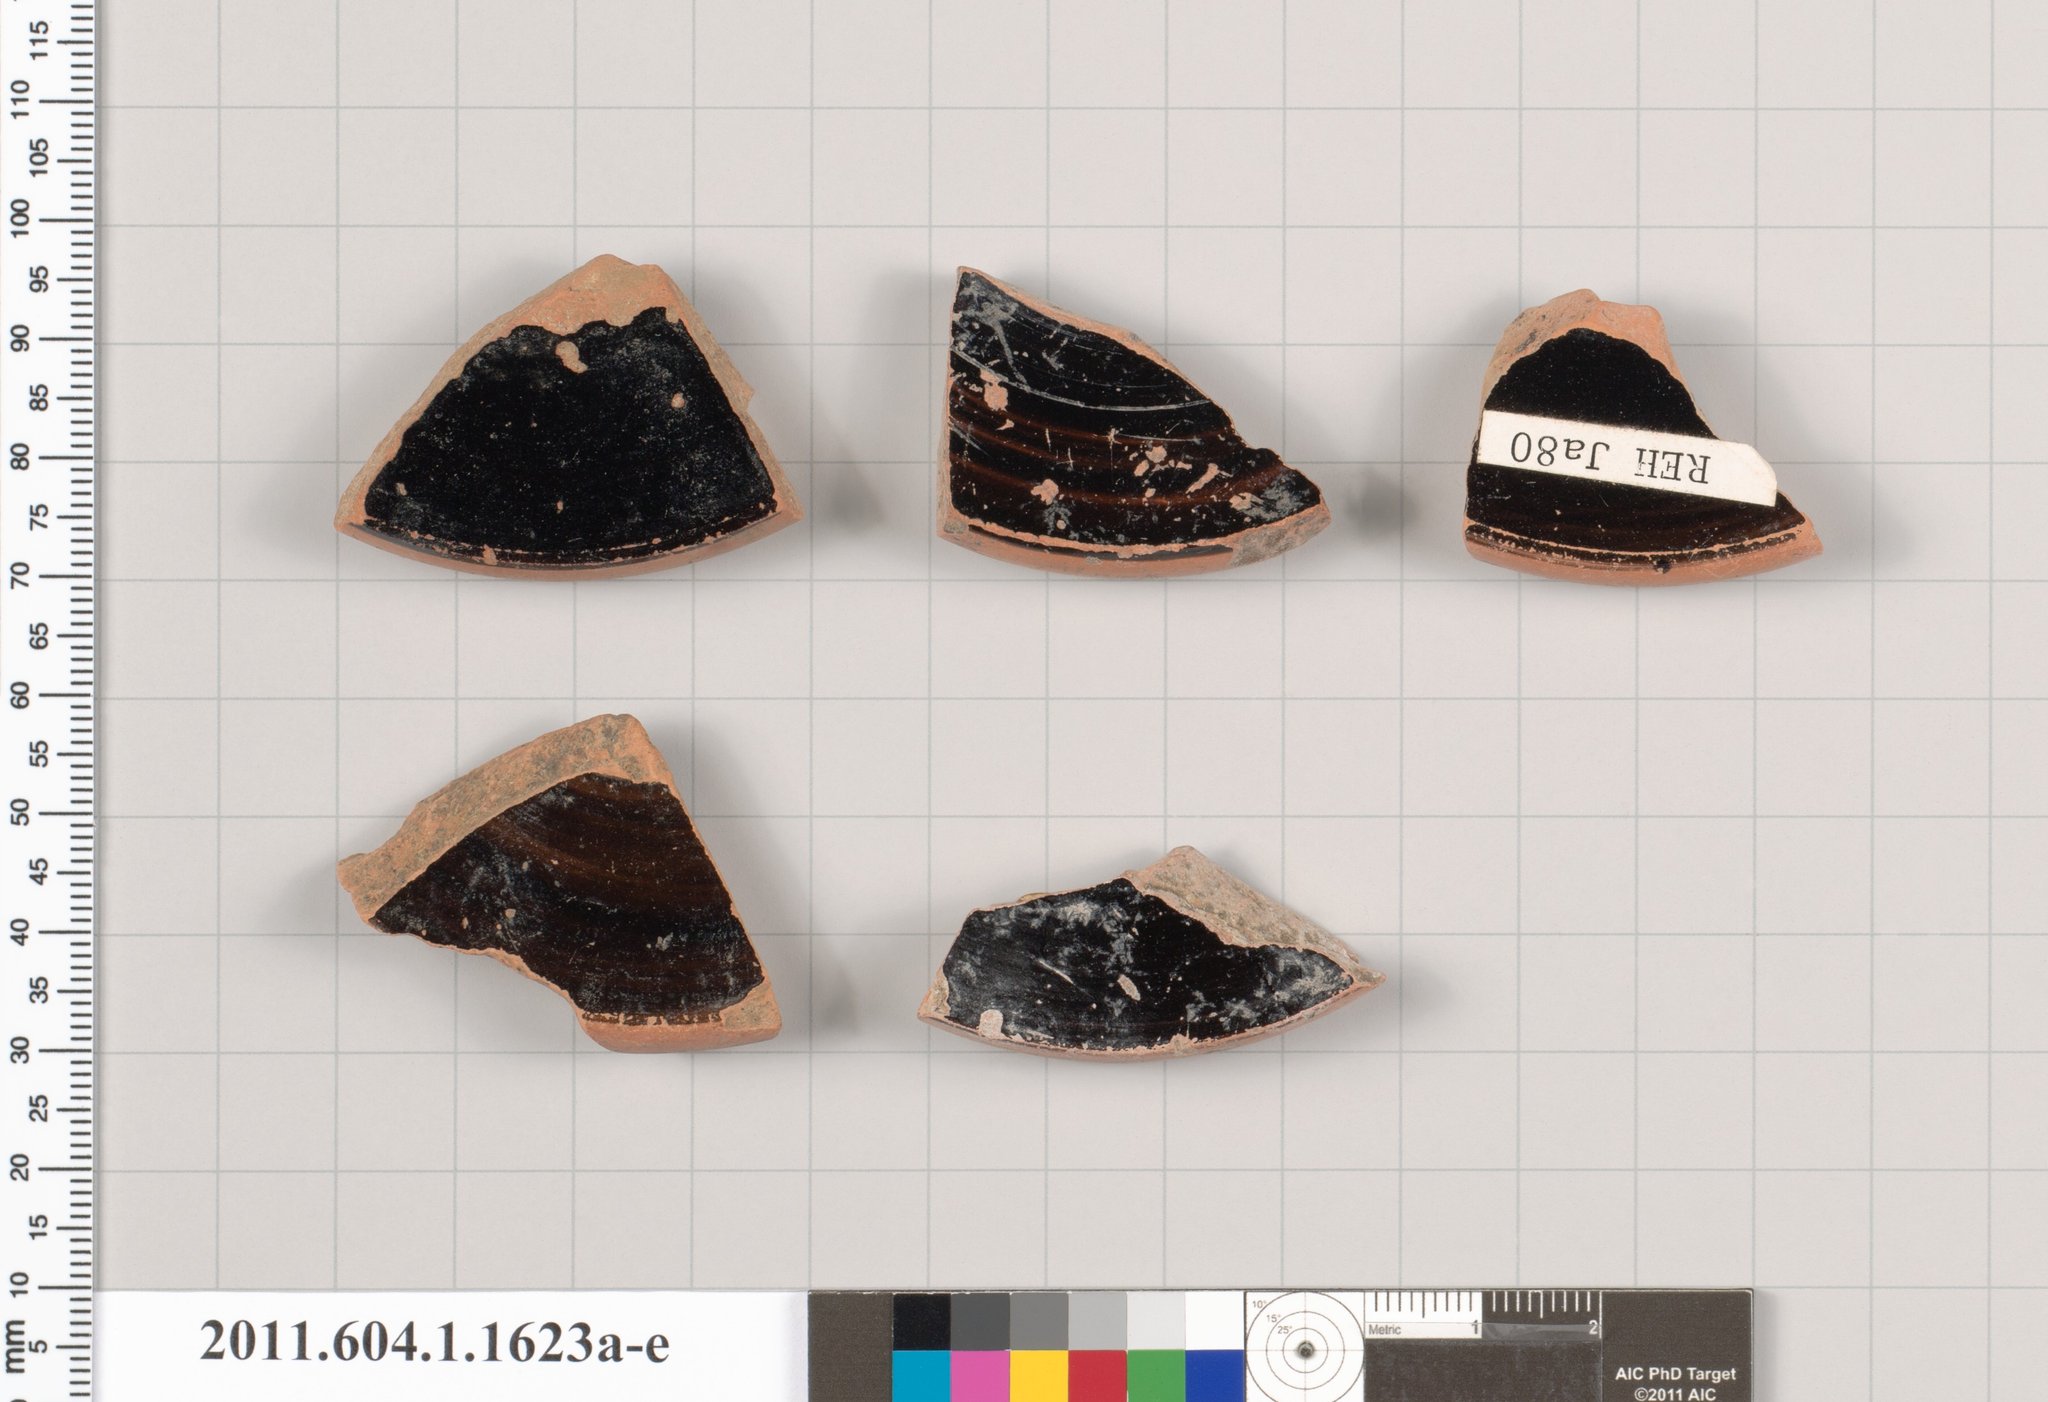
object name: kylix fragment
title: Terracotta fragments of kylikes (drinking cups)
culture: greek, attic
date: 500-401 BCE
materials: terracotta